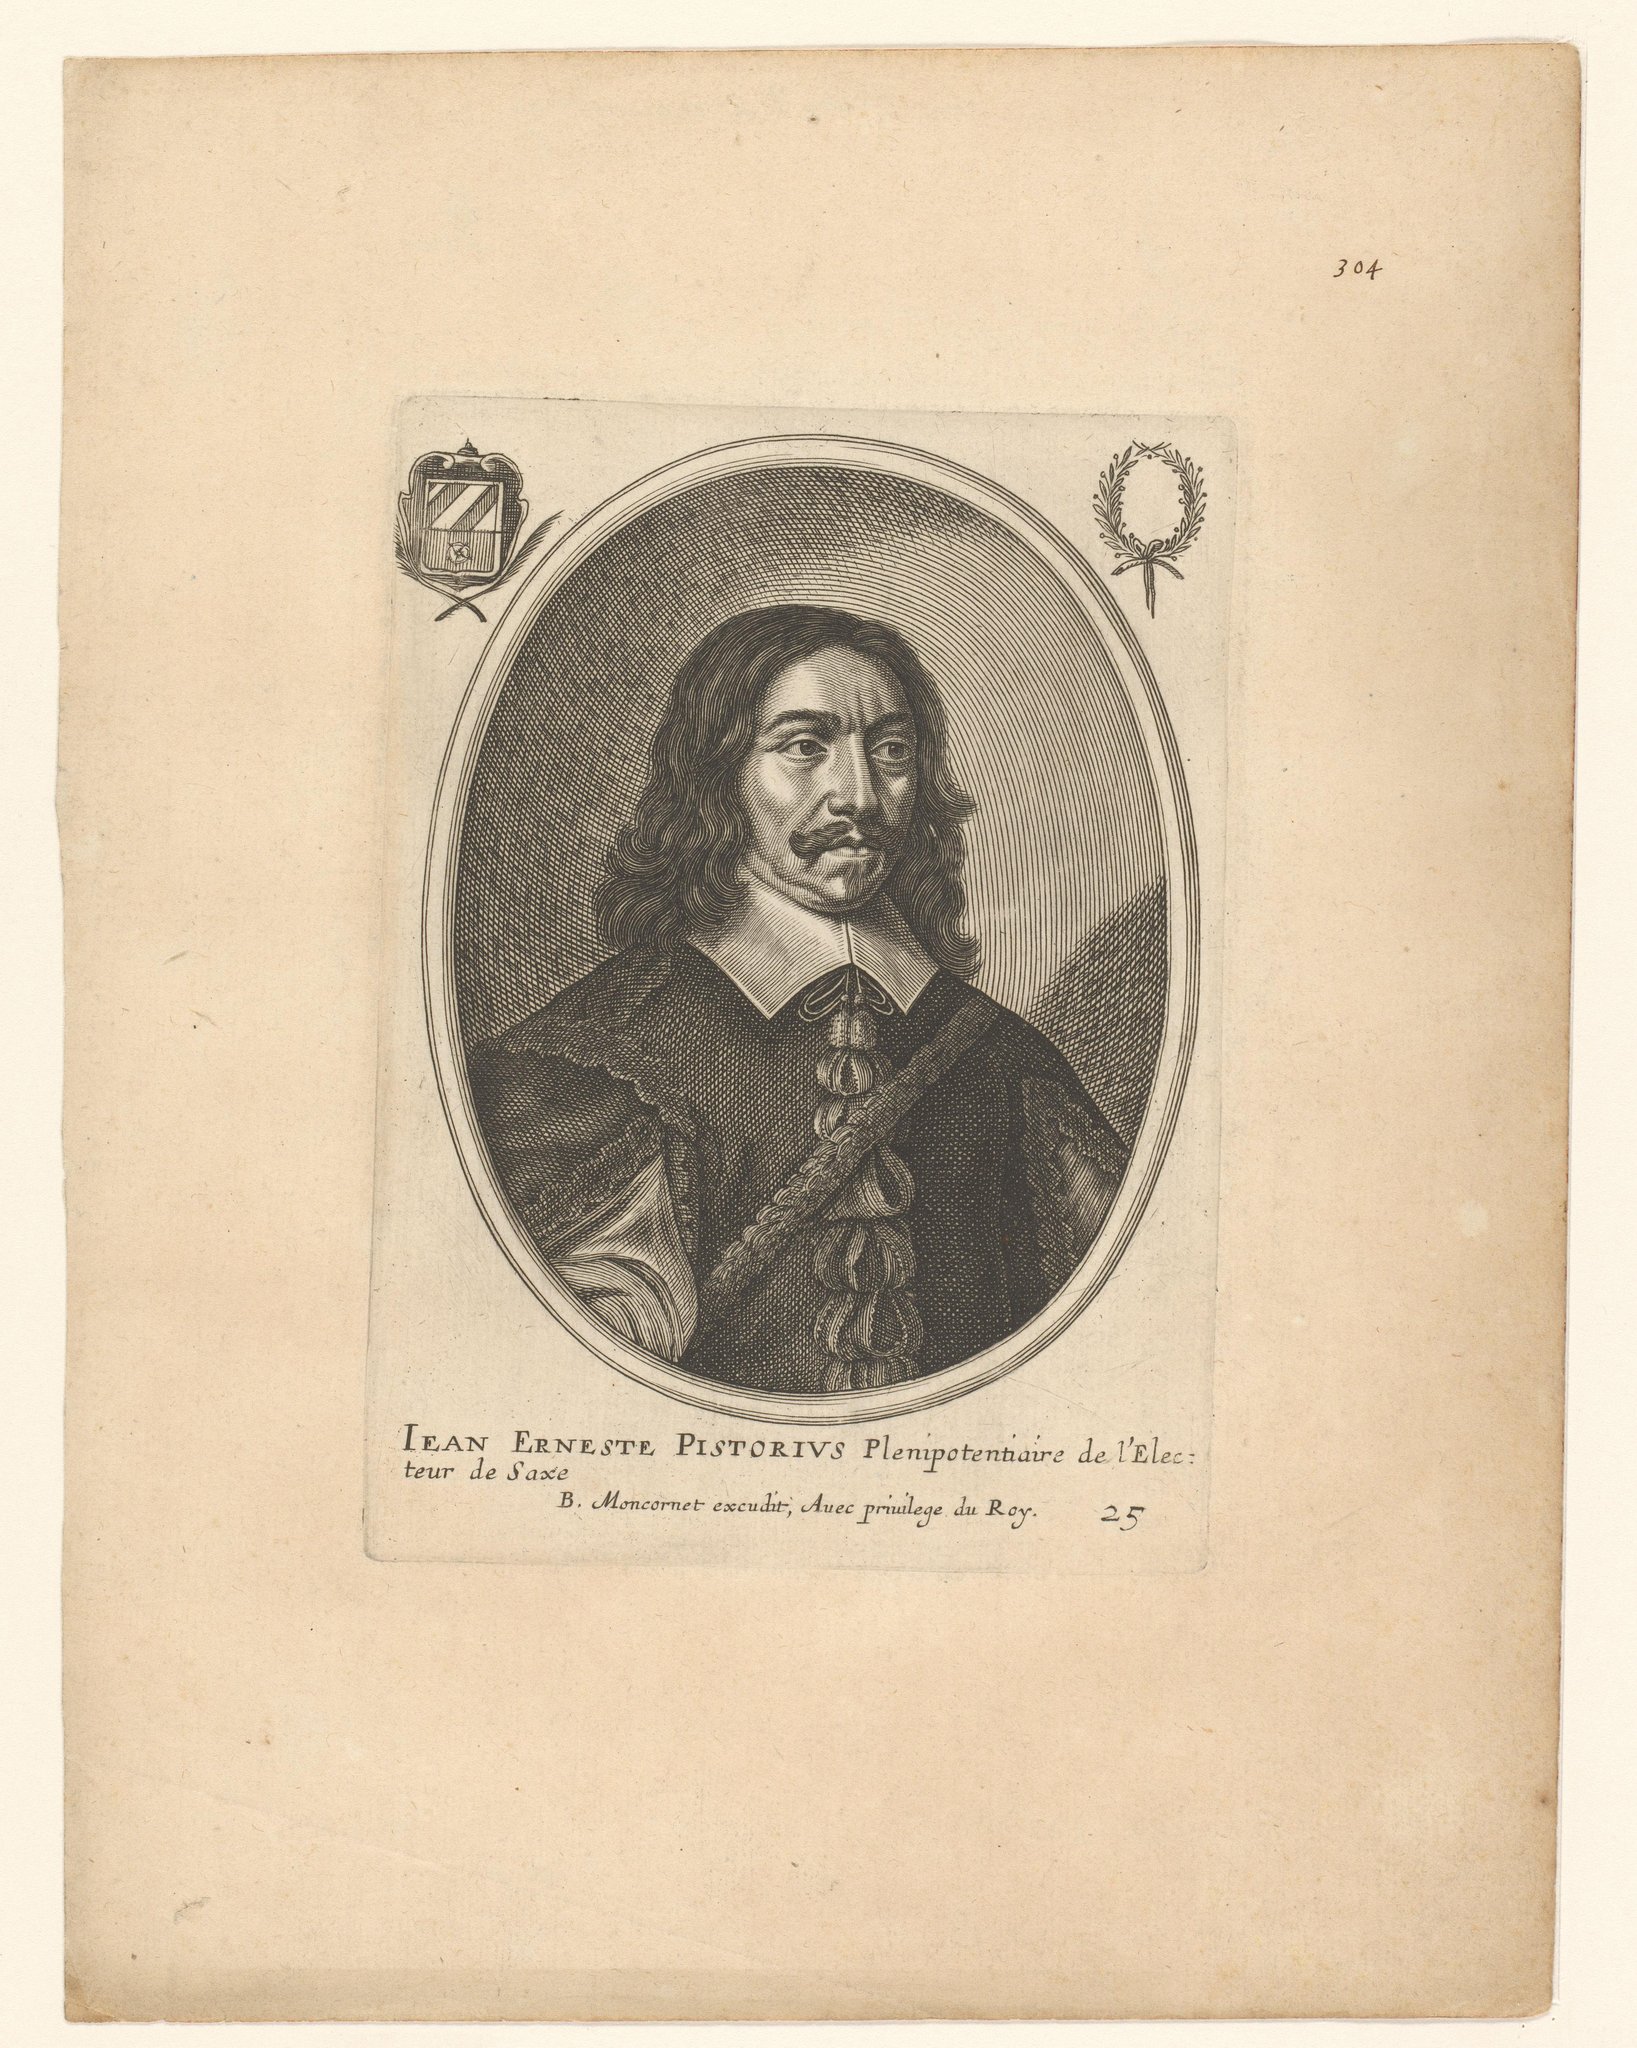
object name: print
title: Portraits, noms, et qualitez des ambassadeurs assemblez tant a Munster qu'Osnabruck (...)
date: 1646-1668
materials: paper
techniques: engraving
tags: historical persons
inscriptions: inscription: ‘304’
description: In een ovaal met linksboven een wapenschild en rechtsboven een lauwerkrans.